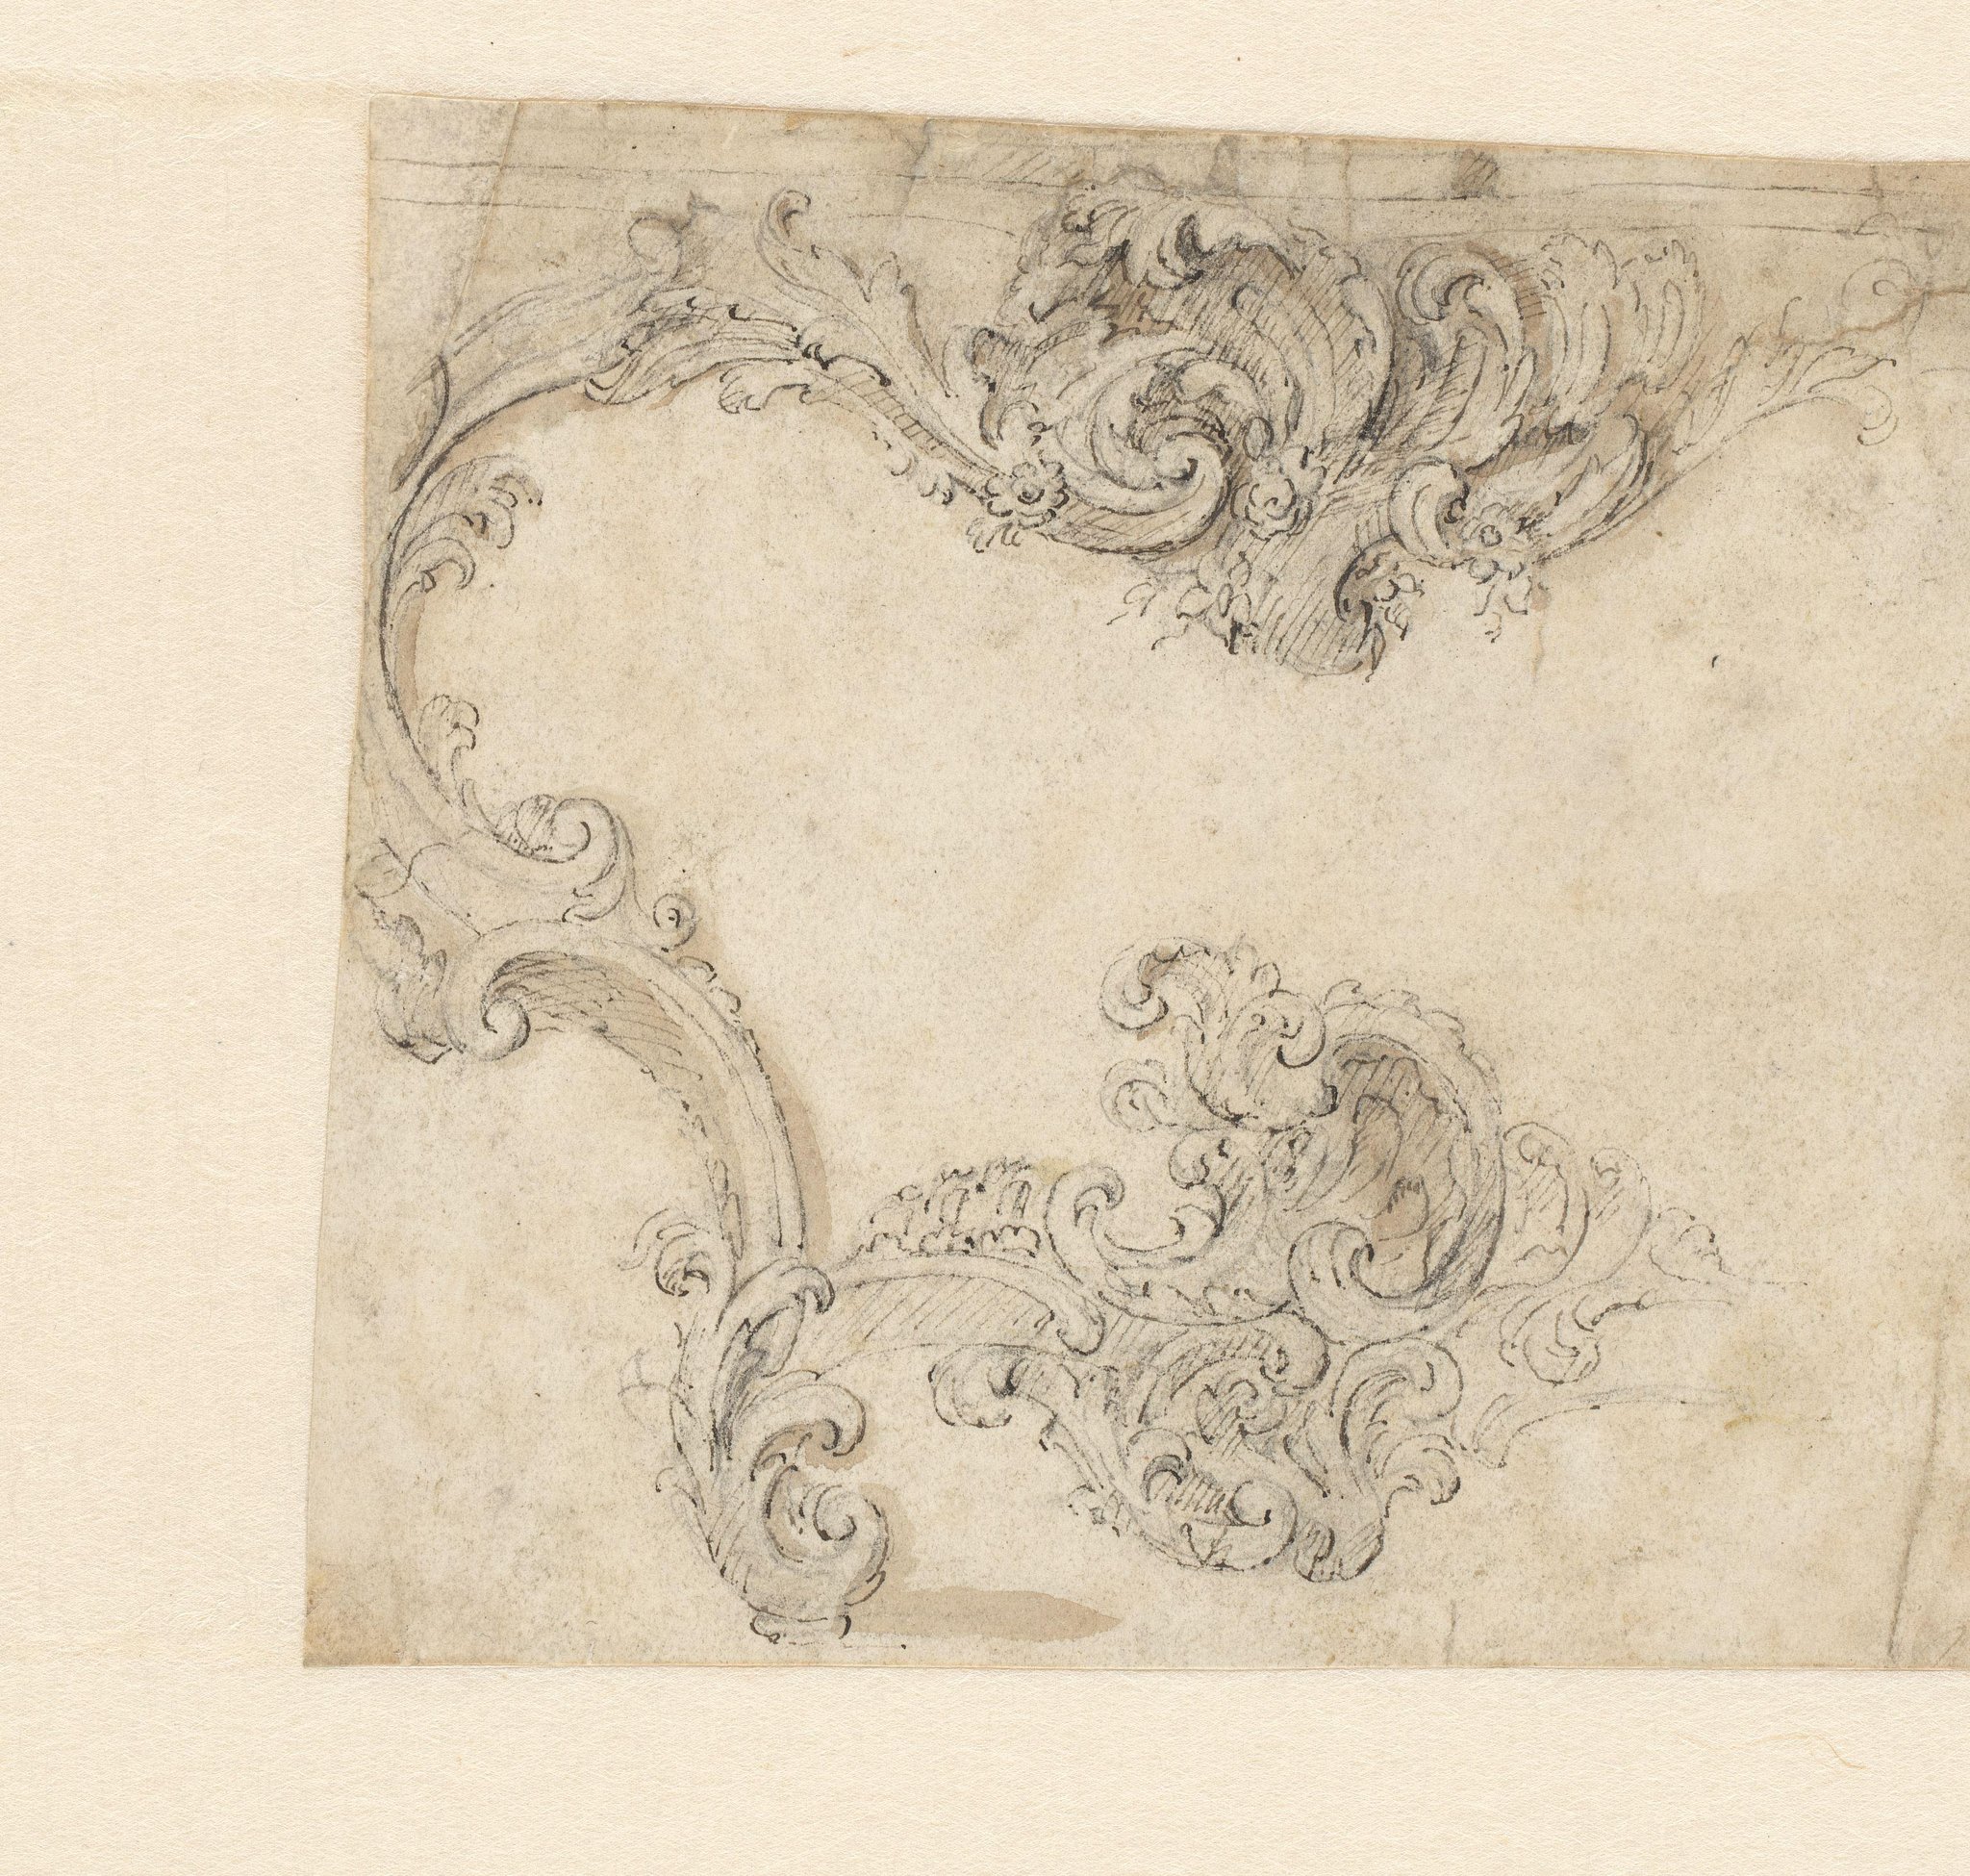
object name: drawing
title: Ontwerp voor een consoletafel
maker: Anonymous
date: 1735-1750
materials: graphite, ink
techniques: brush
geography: france